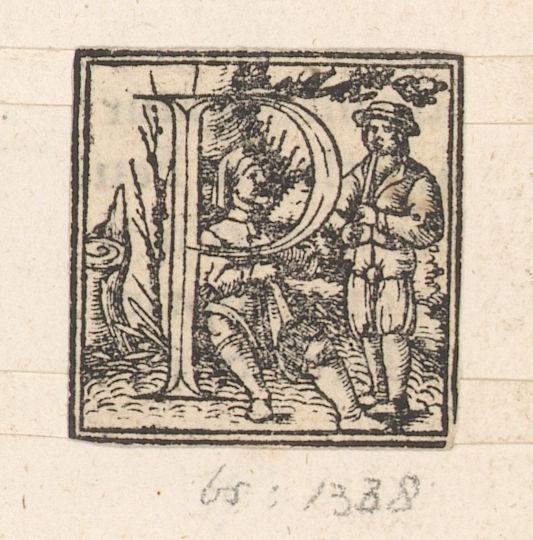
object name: album leaf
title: Initiaal P met twee fluitspelers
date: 1507-1550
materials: paper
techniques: metal cut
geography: switzerland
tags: initial, flute, aulos, tibia - cc - out of doors